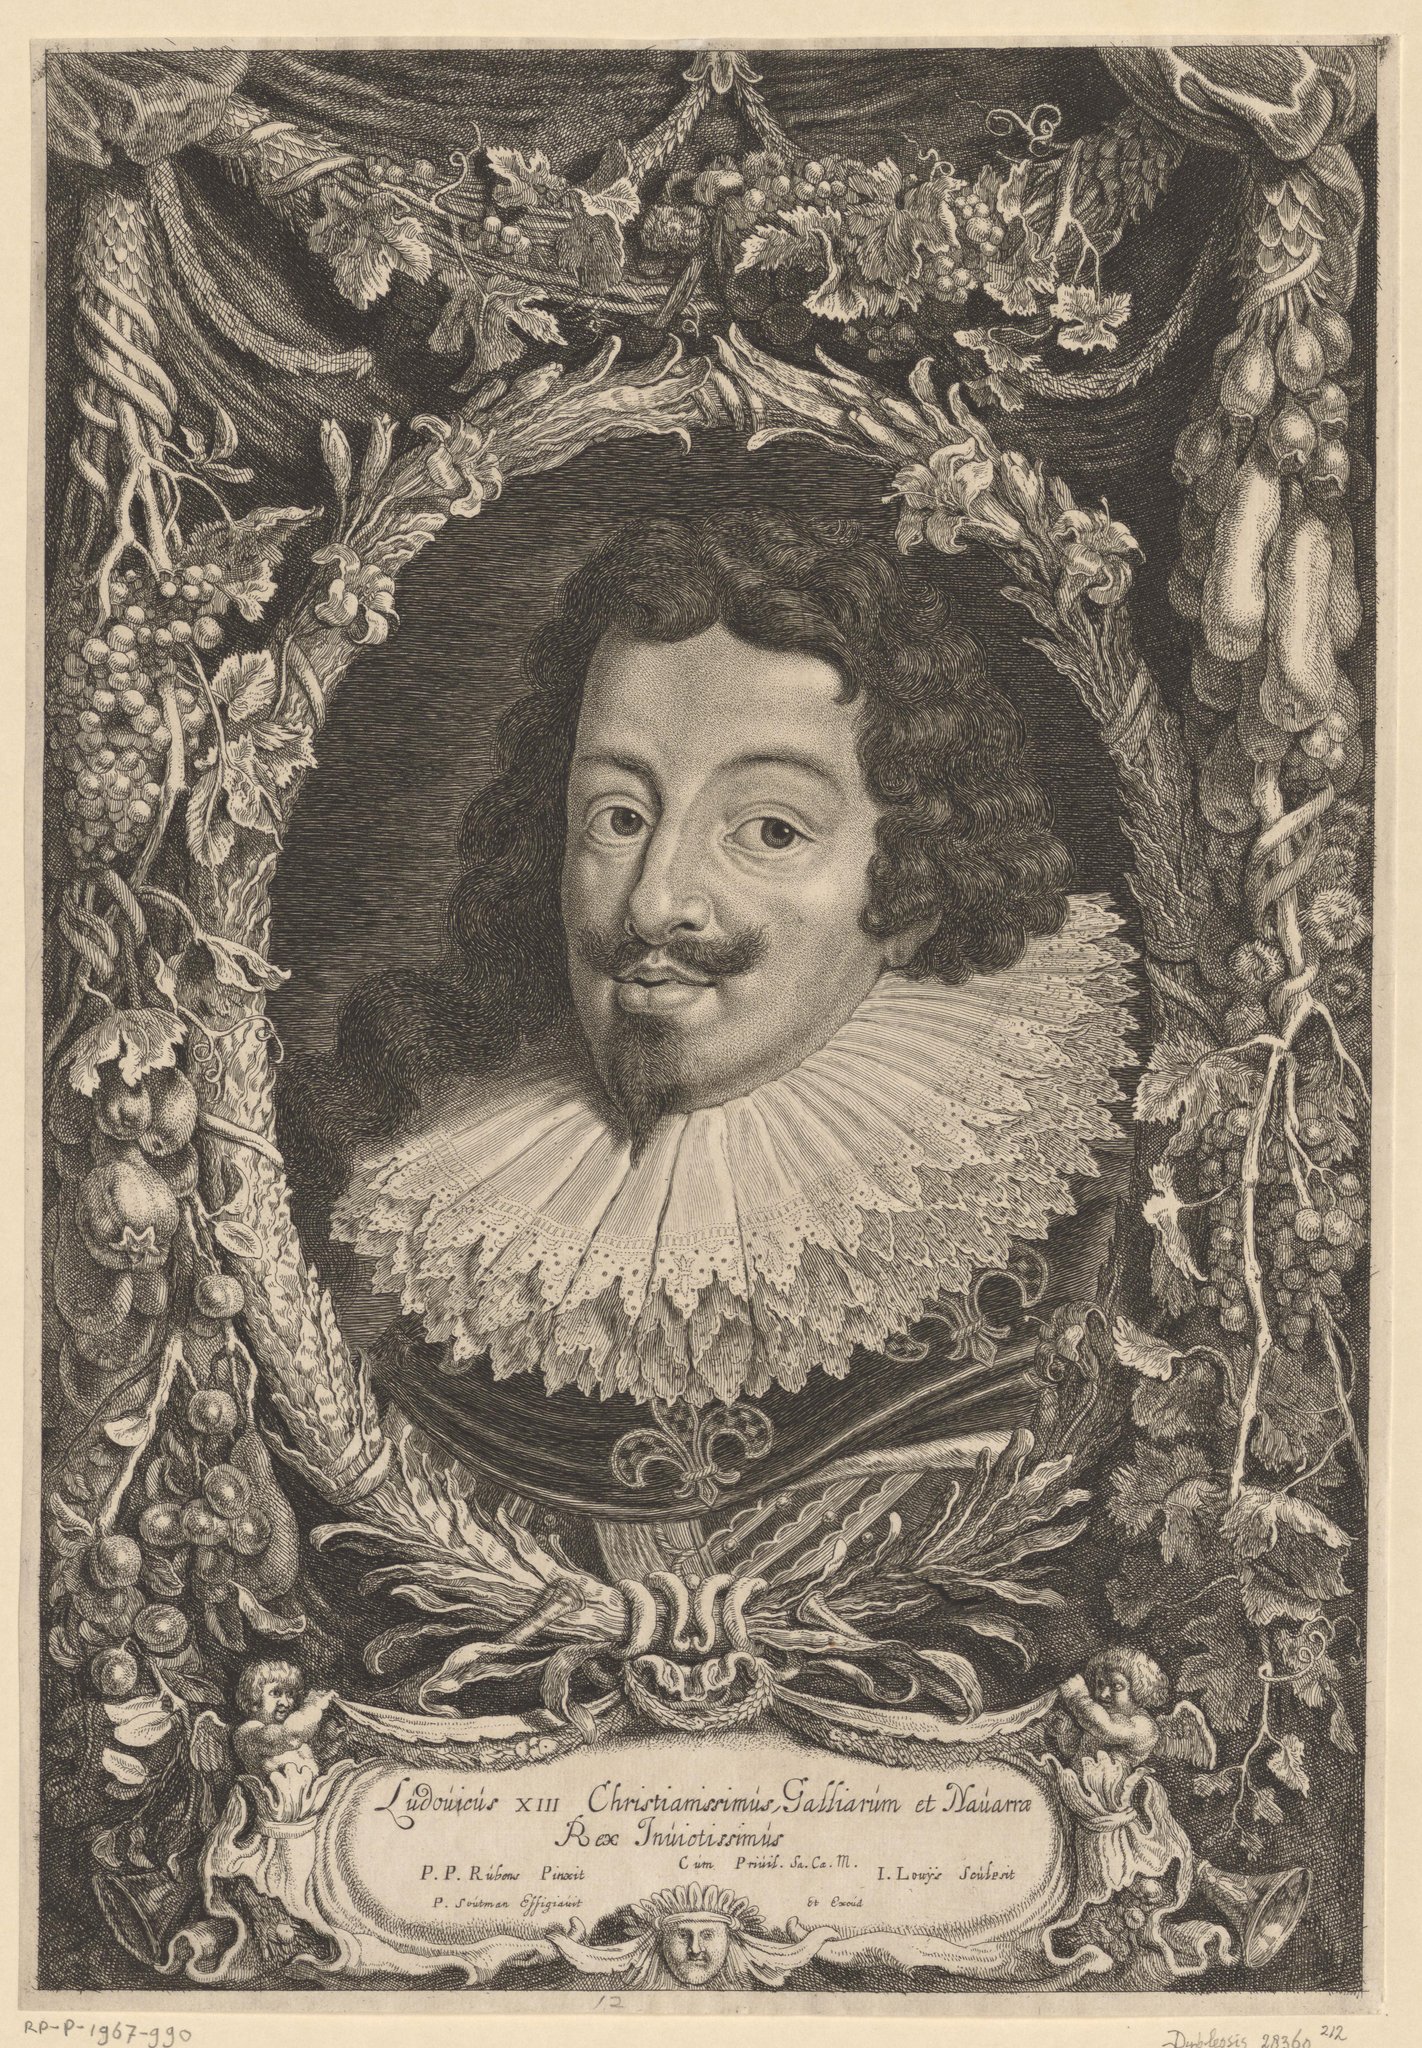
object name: print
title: Portret van Lodewijk XIII, koning van Frankrijk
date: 1644-1650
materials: paper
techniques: engraving, etching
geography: haarlem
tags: lodewijk xiii (koning van frankrijk), historical persons, ornament ~ festoon, garland, fruits, king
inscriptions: collector's mark: Lugt 2228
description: De prenten in de serie Ferdinandus II[us] et III[us] Imperatorum Domus Austriacae zijn vervaardigd door verschillende graveurs: Jonas Suyderhoef, Jacob Louys en Pieter van Sompel.